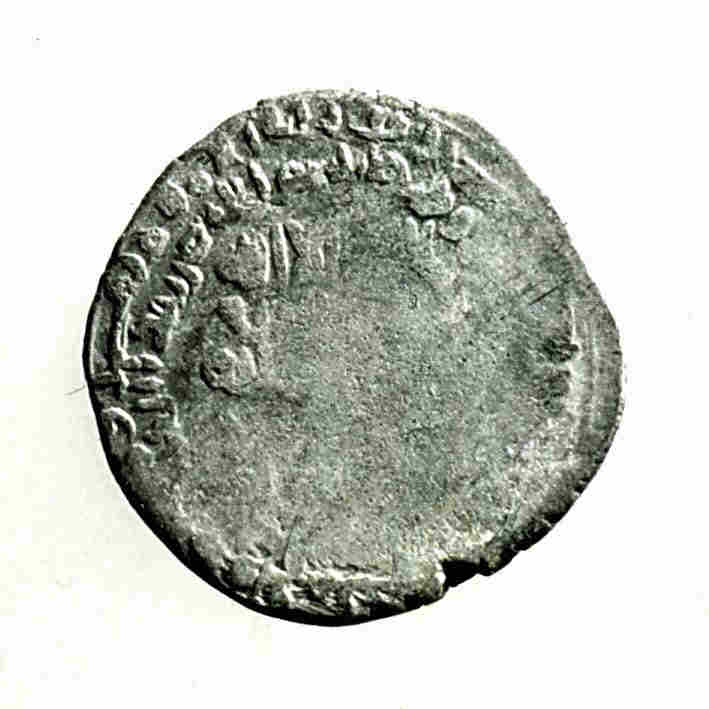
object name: coin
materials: silver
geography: iran